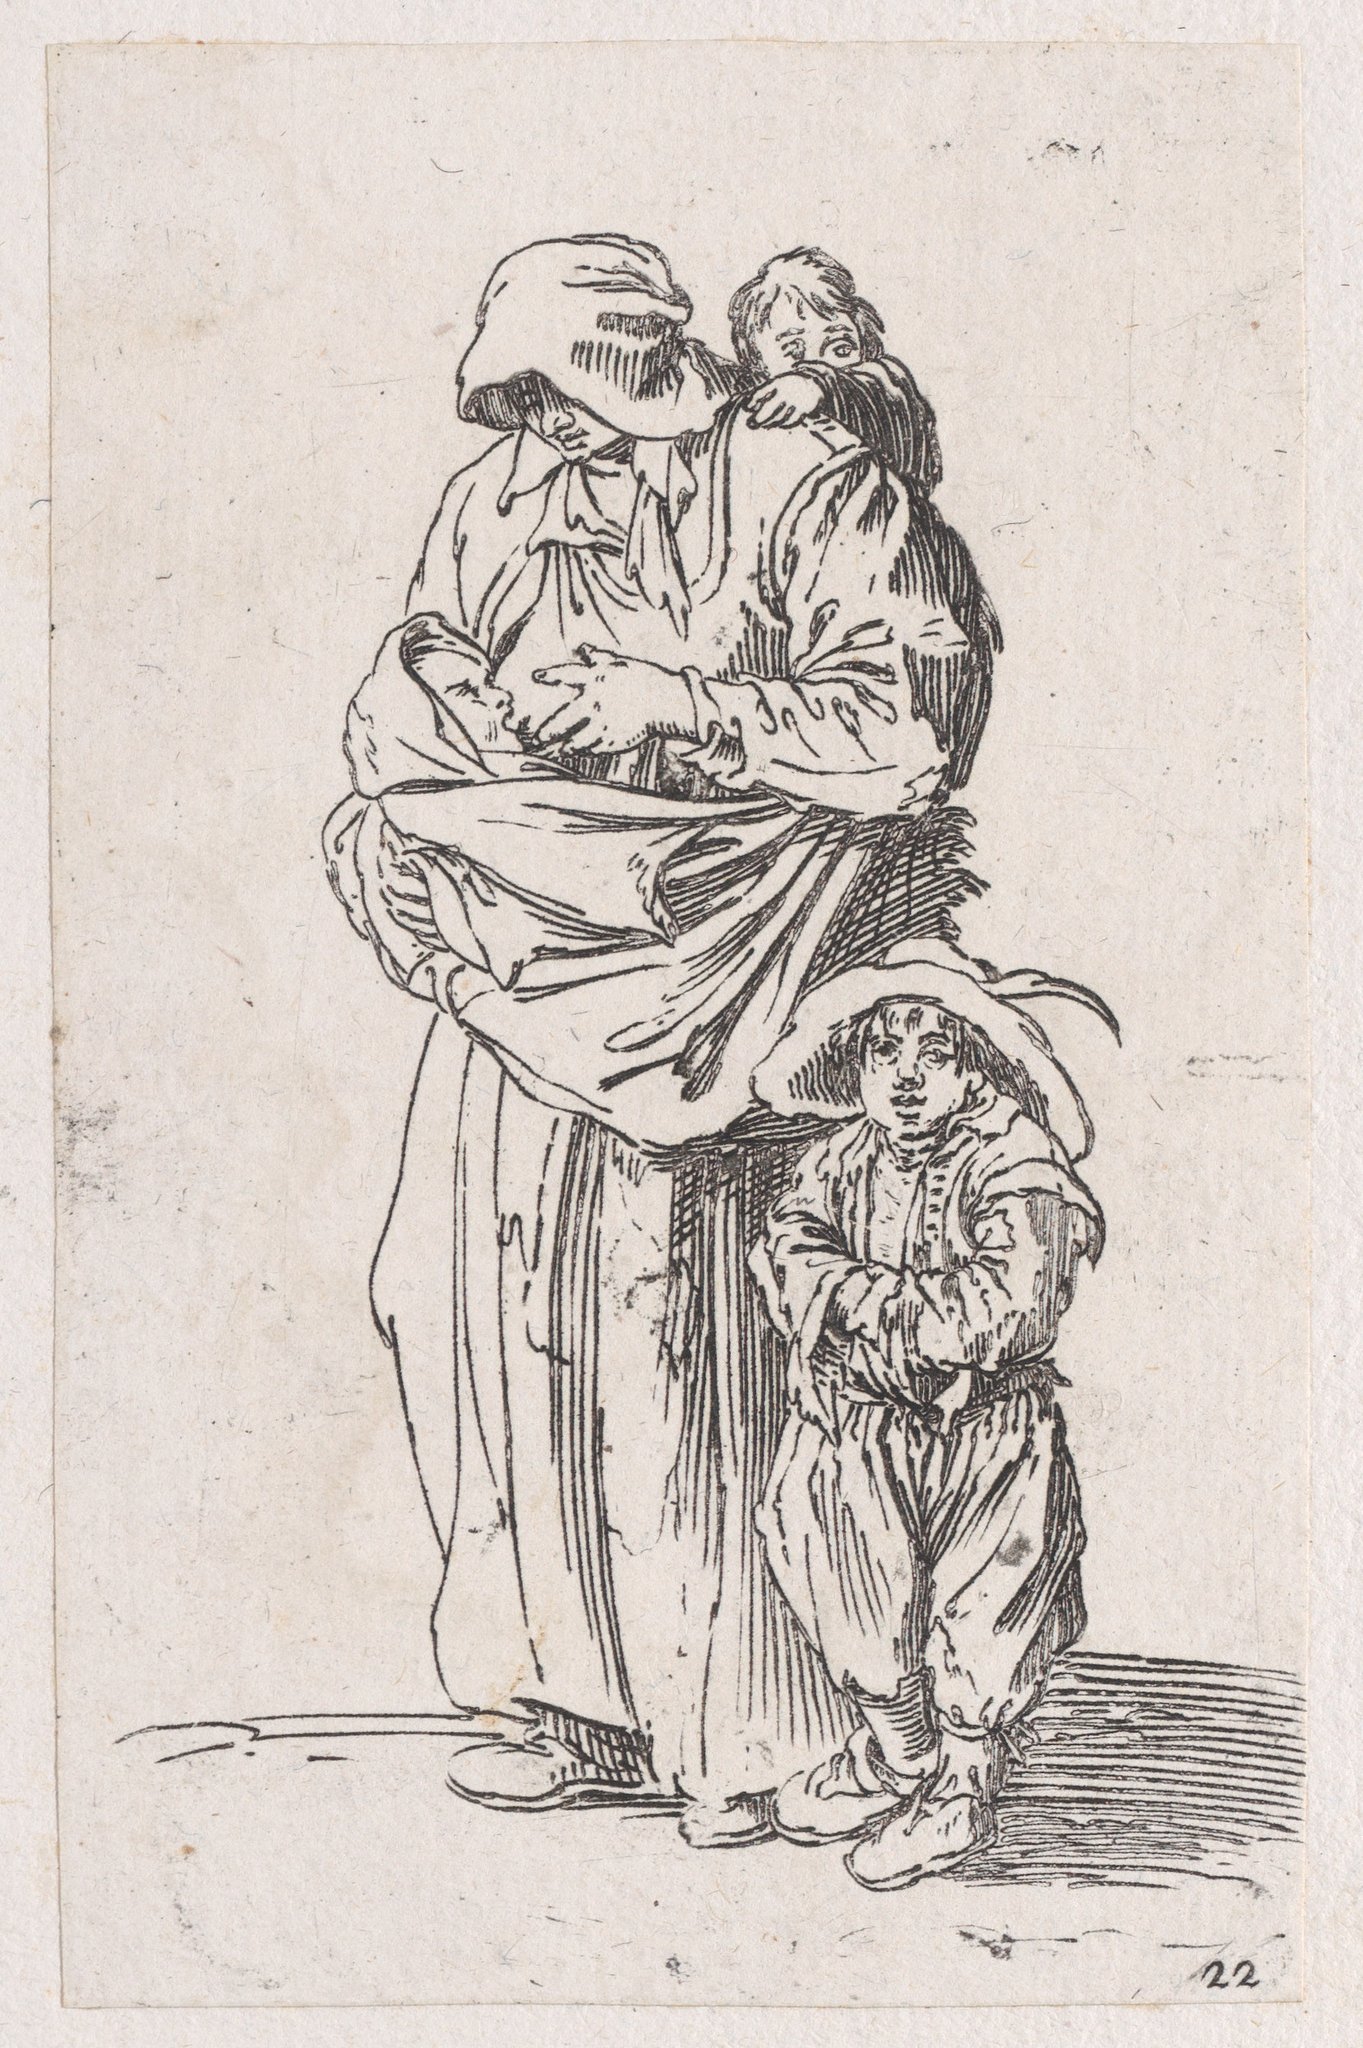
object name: print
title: Reverse Copy of Le Gentilhomme qui Salue Tenant son Feutre sous le Bras (The Gentleman who Bows Holding his Felt Hat under his Arm), from La Noblesse (The Nobility)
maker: Anonymous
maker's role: artist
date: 1601-1700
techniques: etching